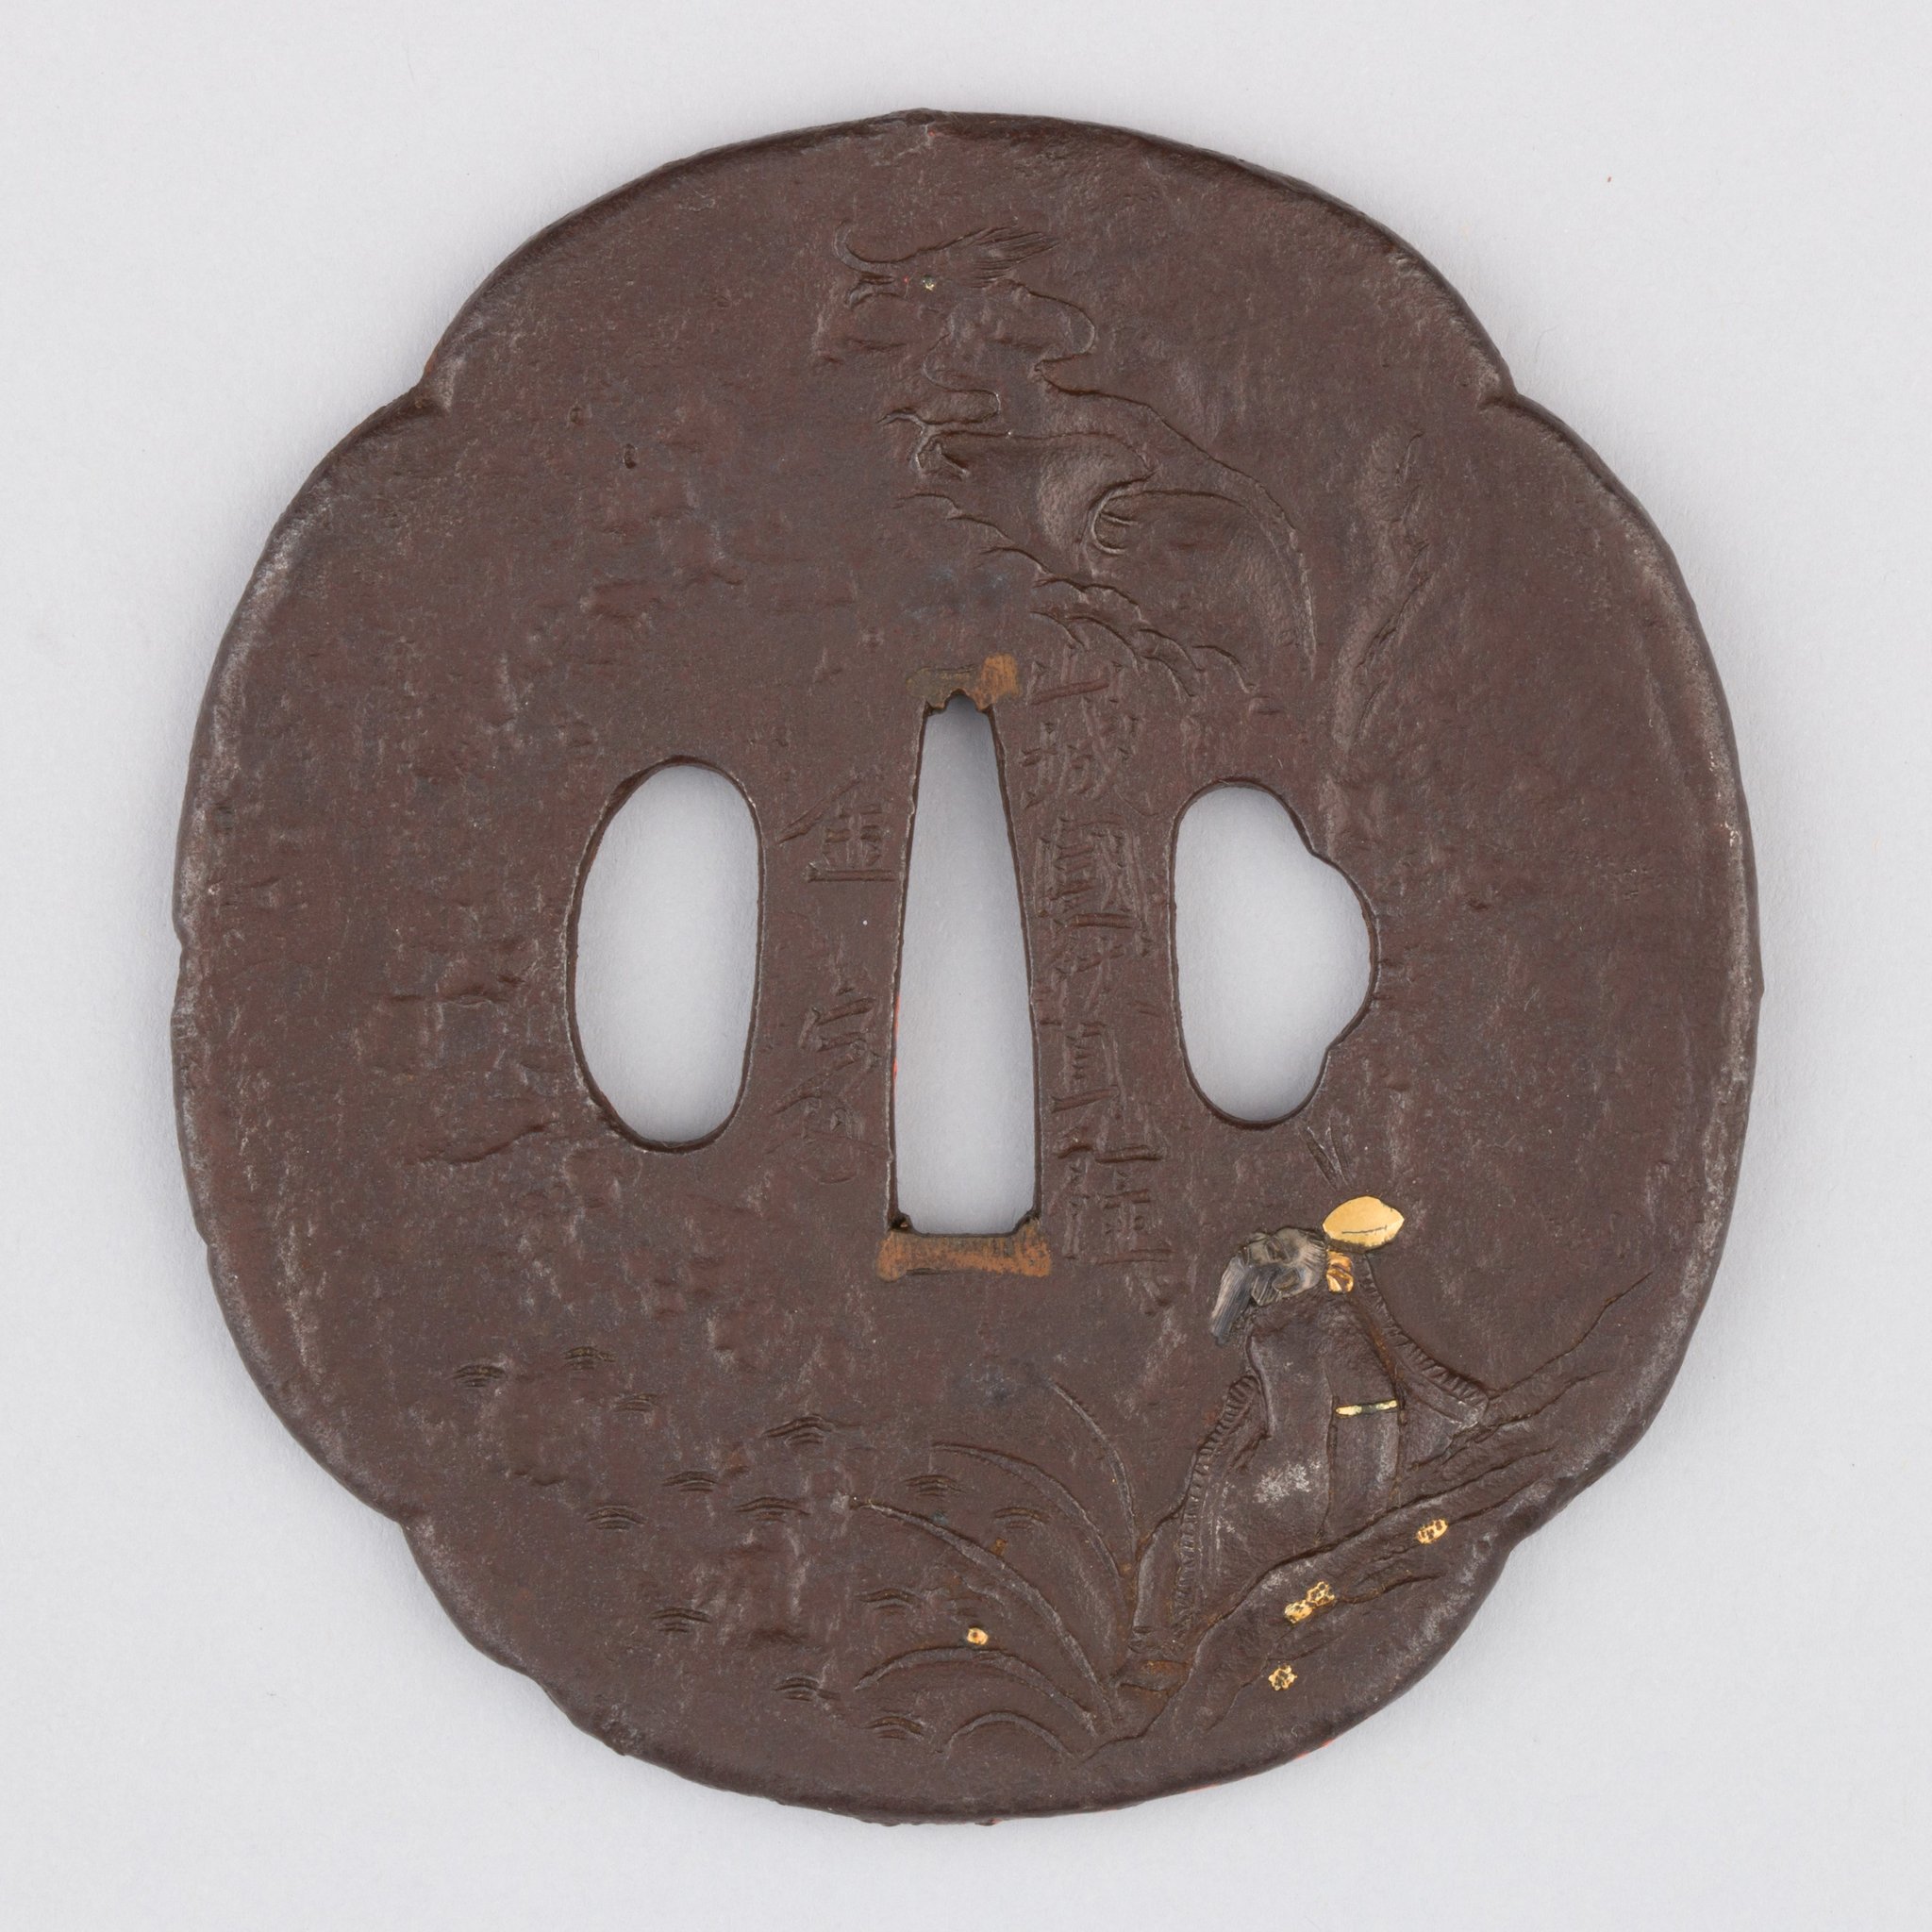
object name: sword guard tsuba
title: Sword Guard (Tsuba)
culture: japanese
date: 1615-1868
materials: copper, iron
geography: japan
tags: men